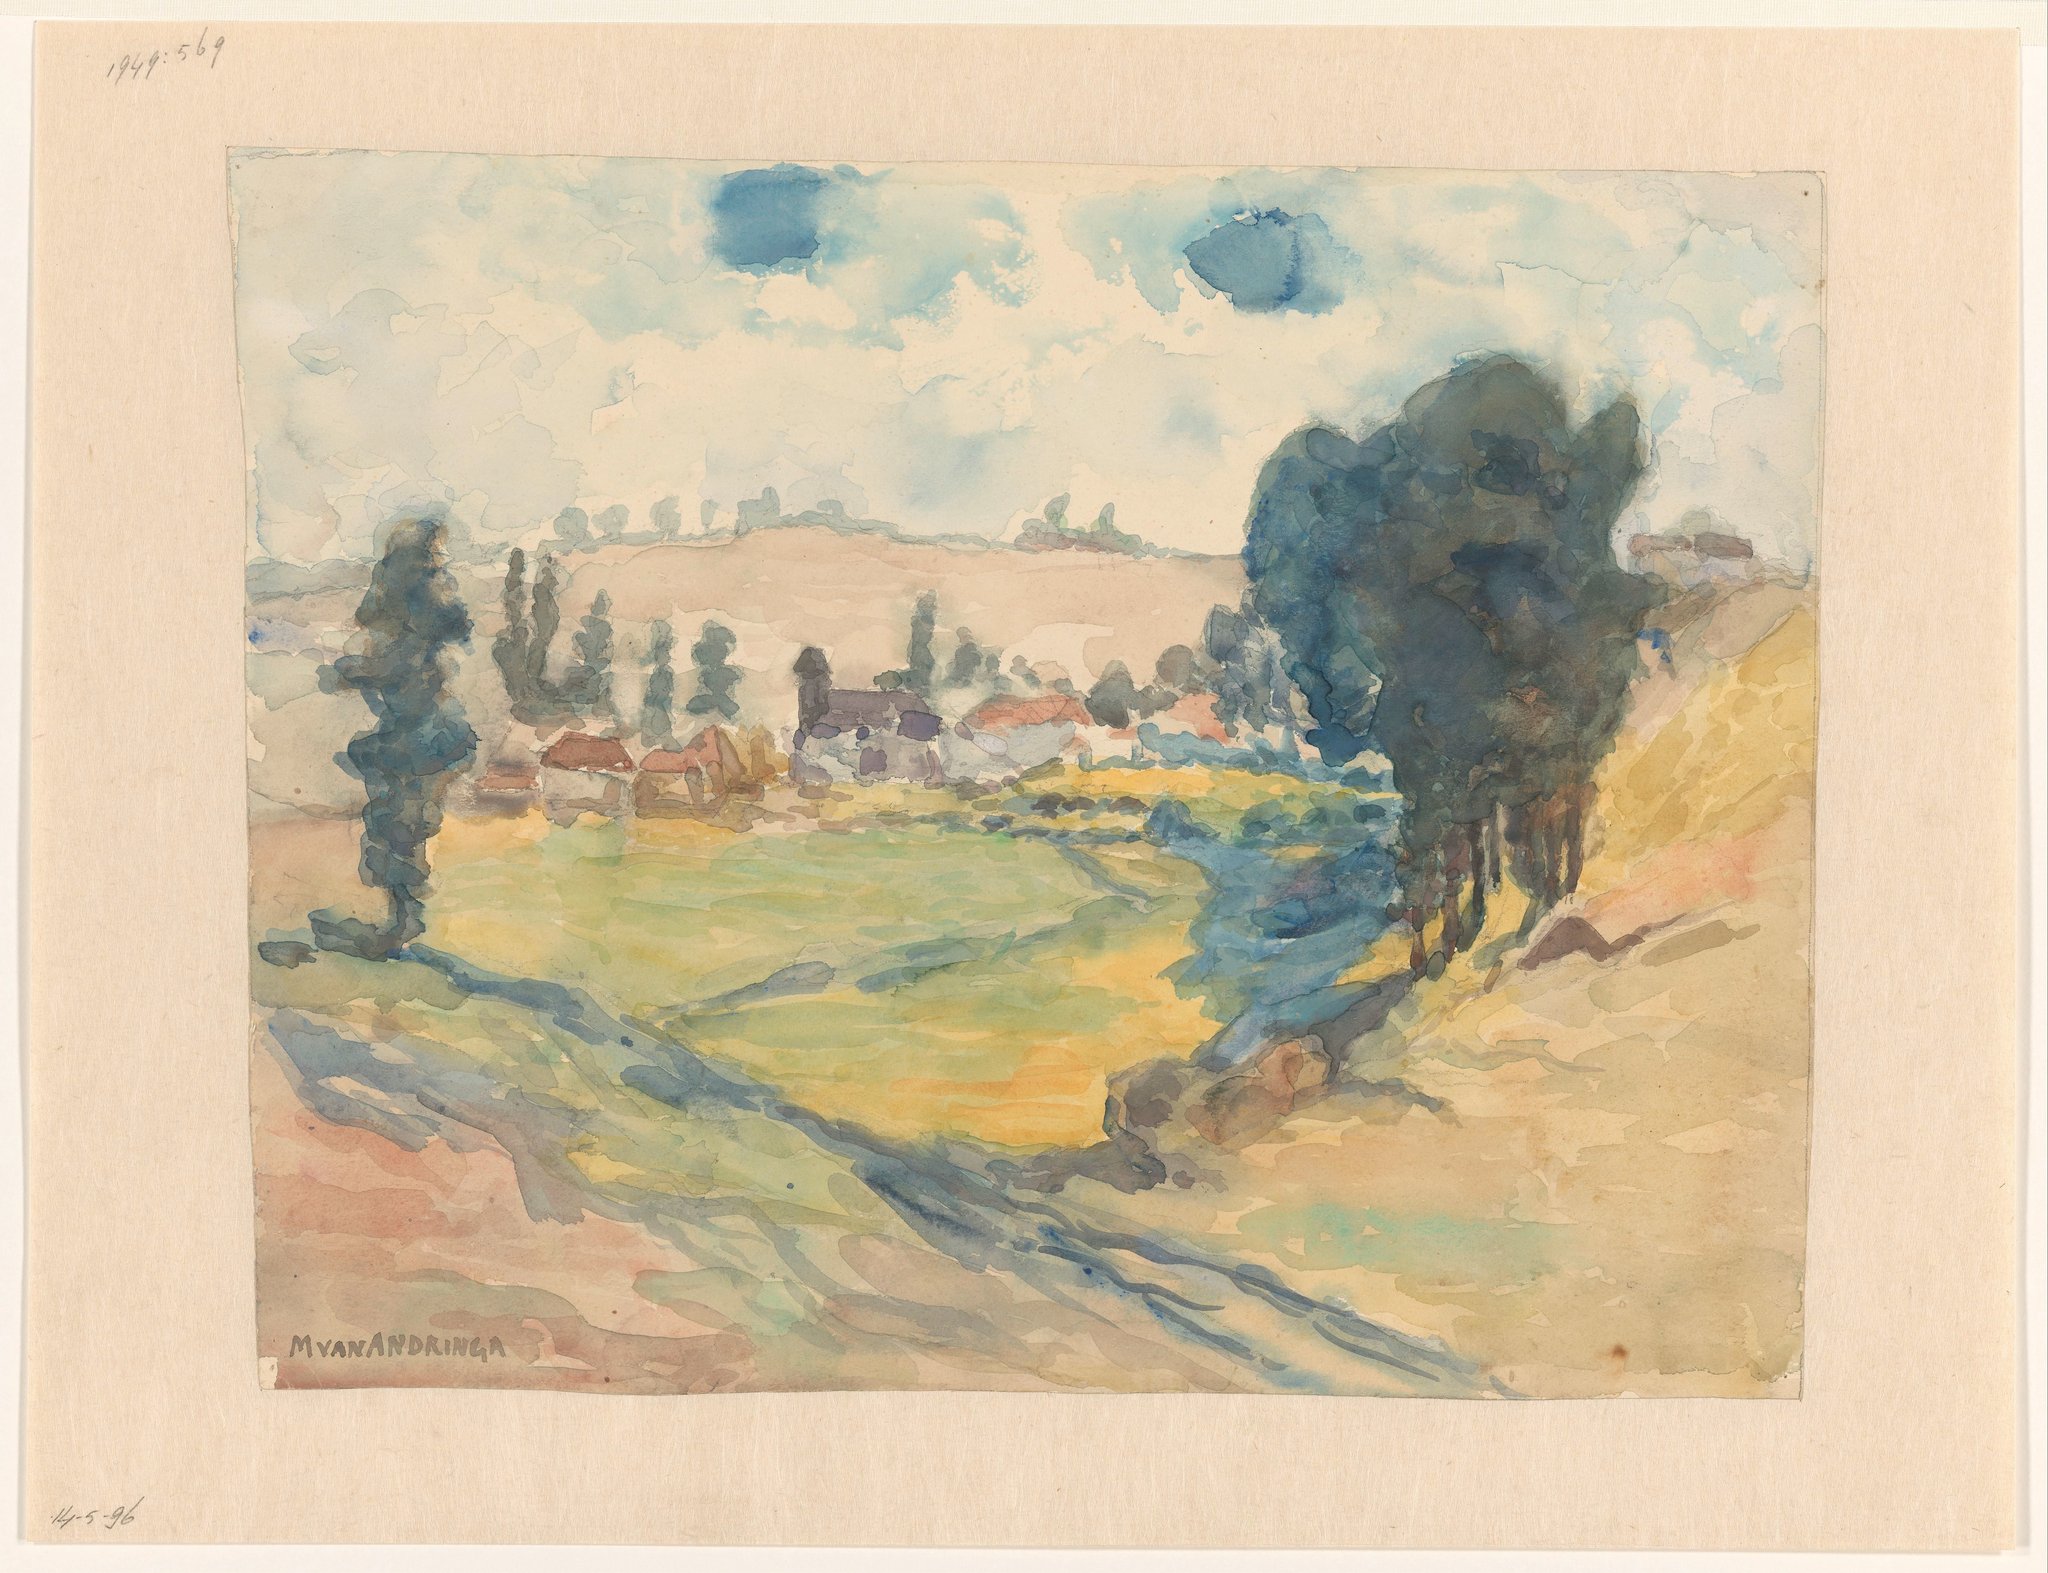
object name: watercolor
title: Heuvellandschap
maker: martinus van andringa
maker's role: draughtsman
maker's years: 1864-1918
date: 1874-1918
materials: chalk, paper, watercolor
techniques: brush